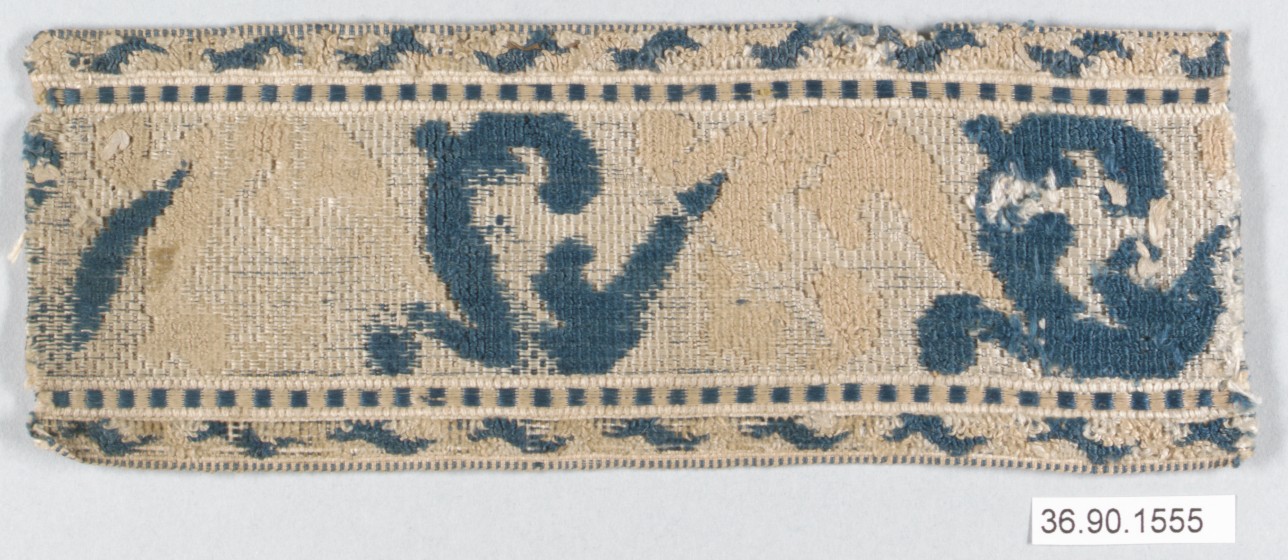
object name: galloon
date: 1701-1900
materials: silk